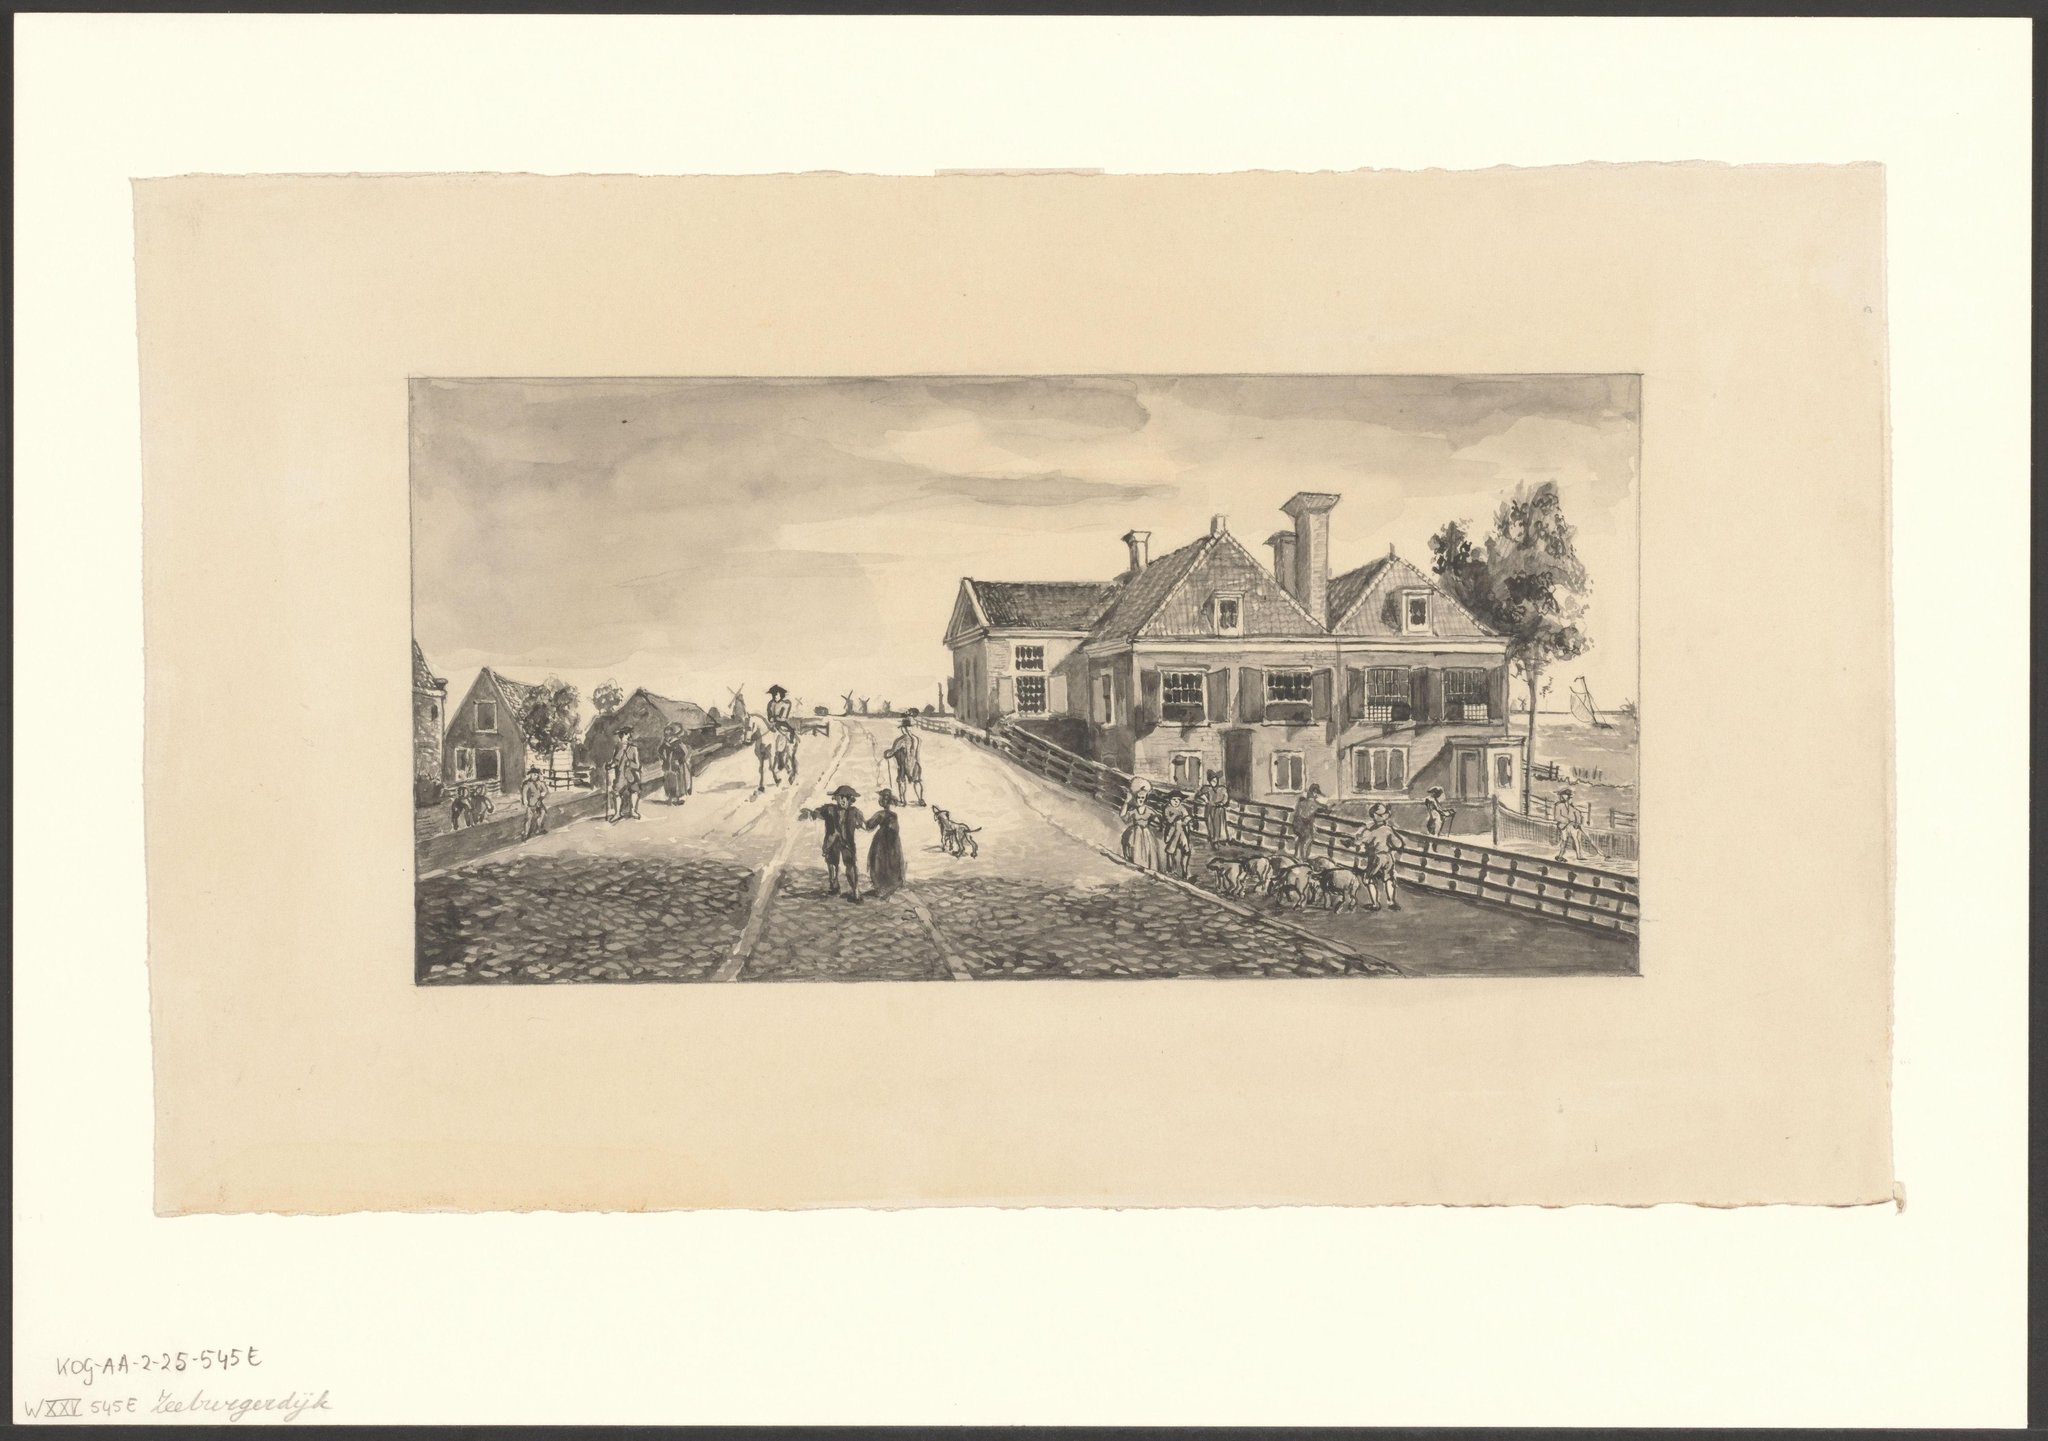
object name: drawing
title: Gezicht op de Zeeburgerdijk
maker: goedkoop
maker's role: draughtsman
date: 1850-1950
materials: ink, paper, pencil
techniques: brush, pen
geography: amsterdam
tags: city-view in general; 'veduta', street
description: Tekening binnen de Atlas Van Eck ingedeeld op wijknummer 25.